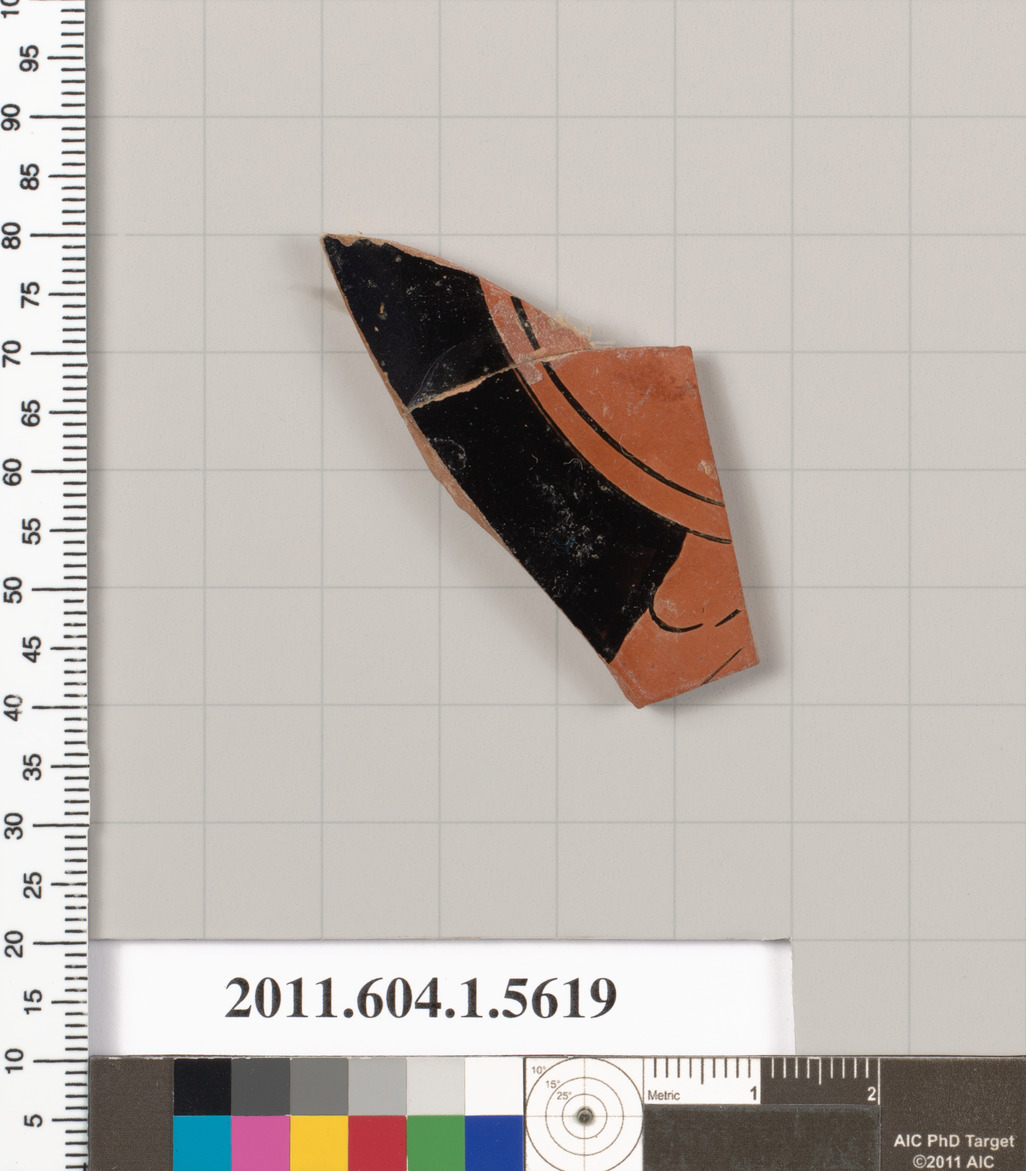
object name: kylix fragment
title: Terracotta fragment of a kylix (drinking cup)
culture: greek, attic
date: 520-500 BCE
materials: terracotta